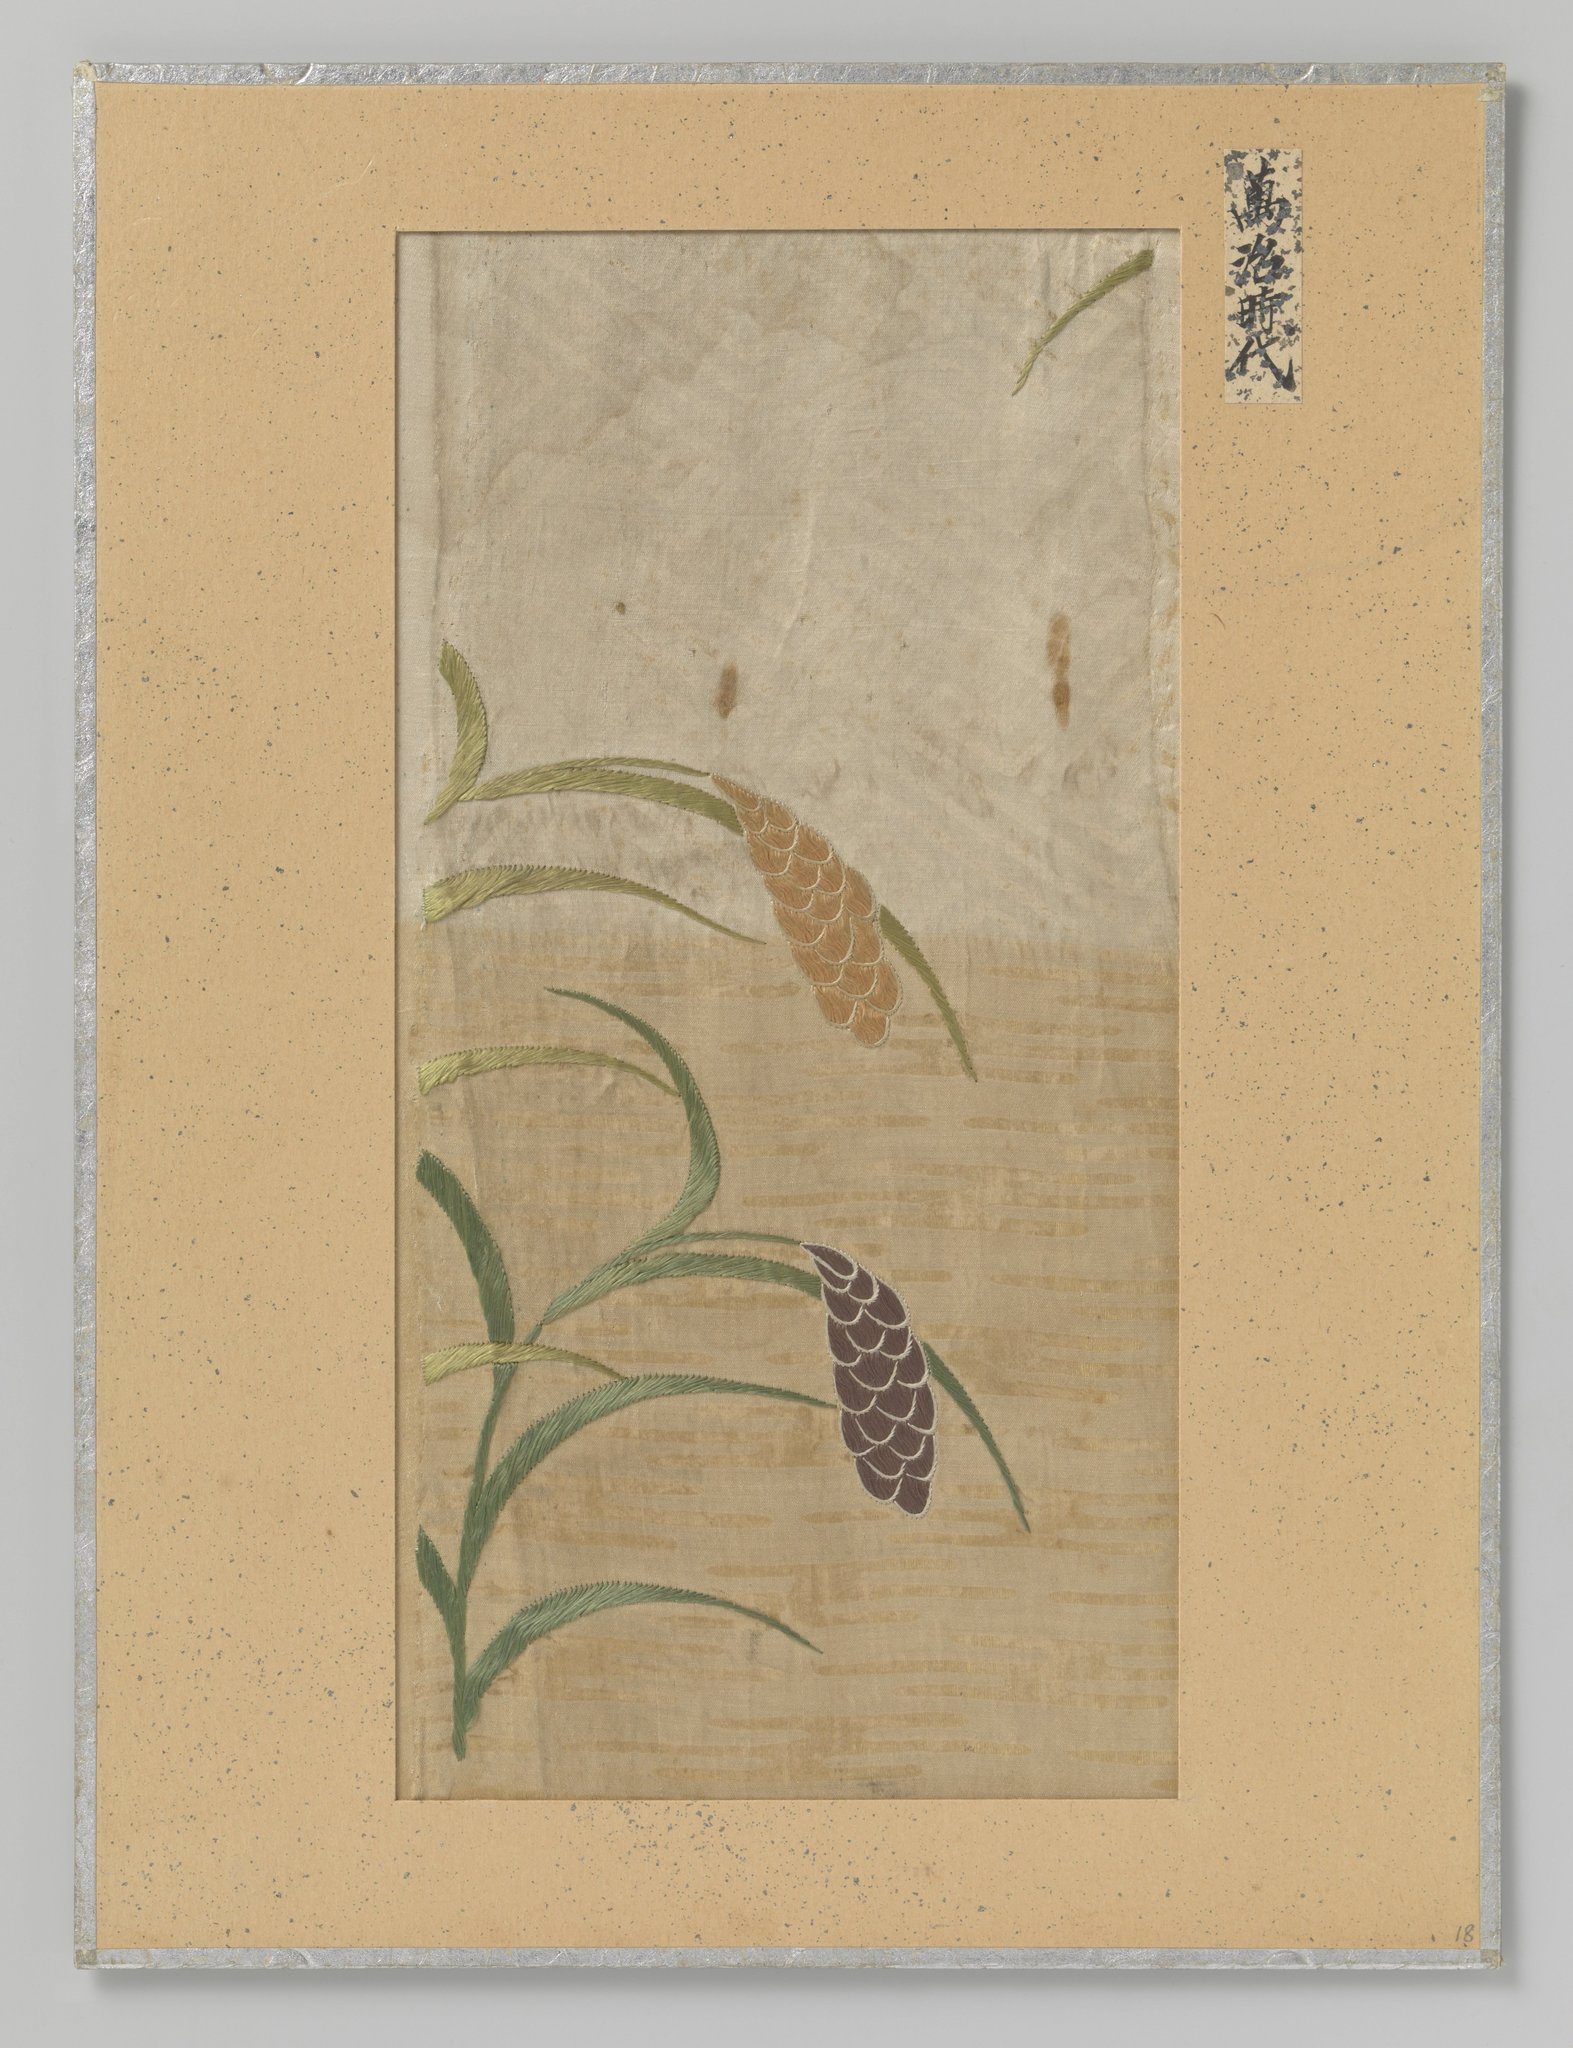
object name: fragment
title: Fragment textiel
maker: Anonymous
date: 1658-1661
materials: silk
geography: japan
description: Textielfragment, borduursel van korenaren op zijden damast.